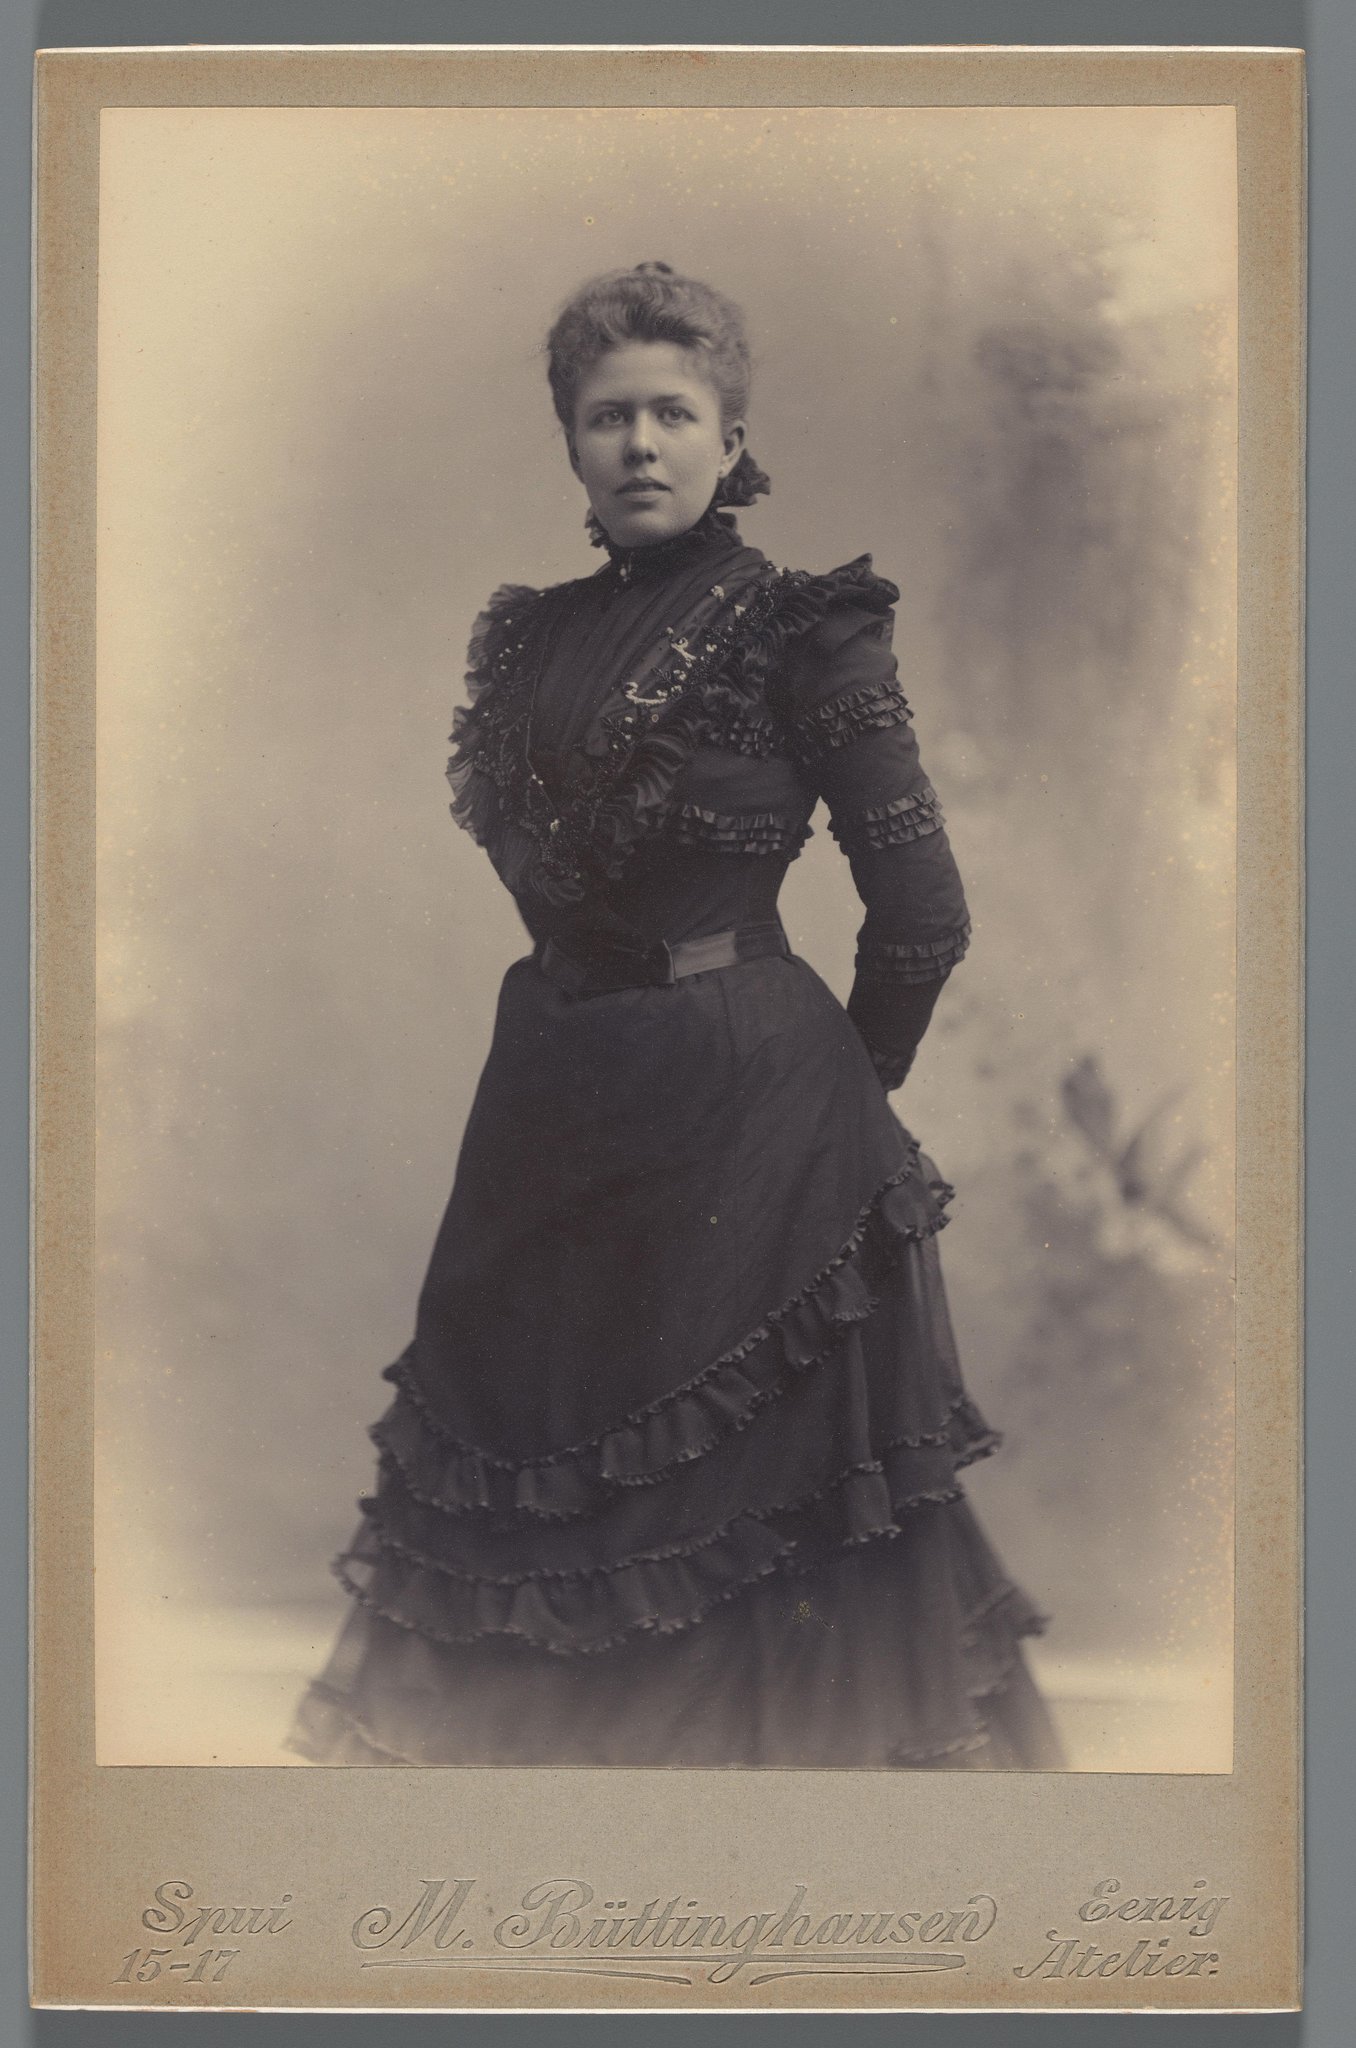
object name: cabinet photograph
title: Studioportret van Poppy Dunlop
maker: max büttinghausen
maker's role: fotograaf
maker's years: 1847-1906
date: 1870-1906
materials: cardboard, photographic support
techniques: albumen print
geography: spui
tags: batavia, amsterdam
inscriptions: name, inscription: ‘Spui / 15 - 17 / M. Büttinghausen / Eenig / Atelier.’